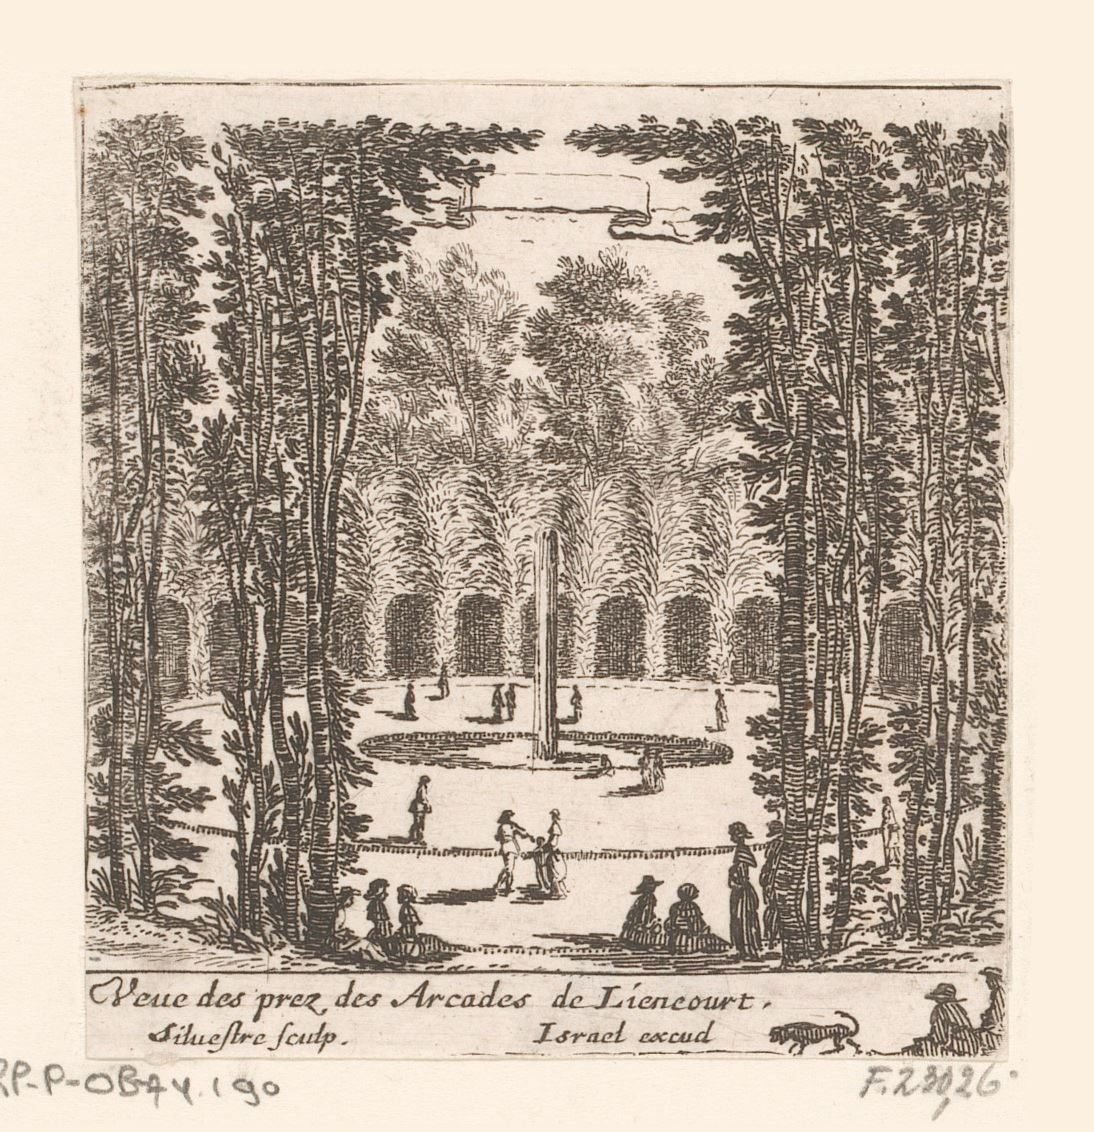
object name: print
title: Gezicht op arcades van bomen rond een fontein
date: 1655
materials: paper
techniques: engraving, etching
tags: garden fountain, french or architectonic garden; formal garden, landscape with tower or castle, paris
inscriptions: collector's mark: Lugt 240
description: Prent maakt deel uit van een ongenummerde serie van tien prenten.